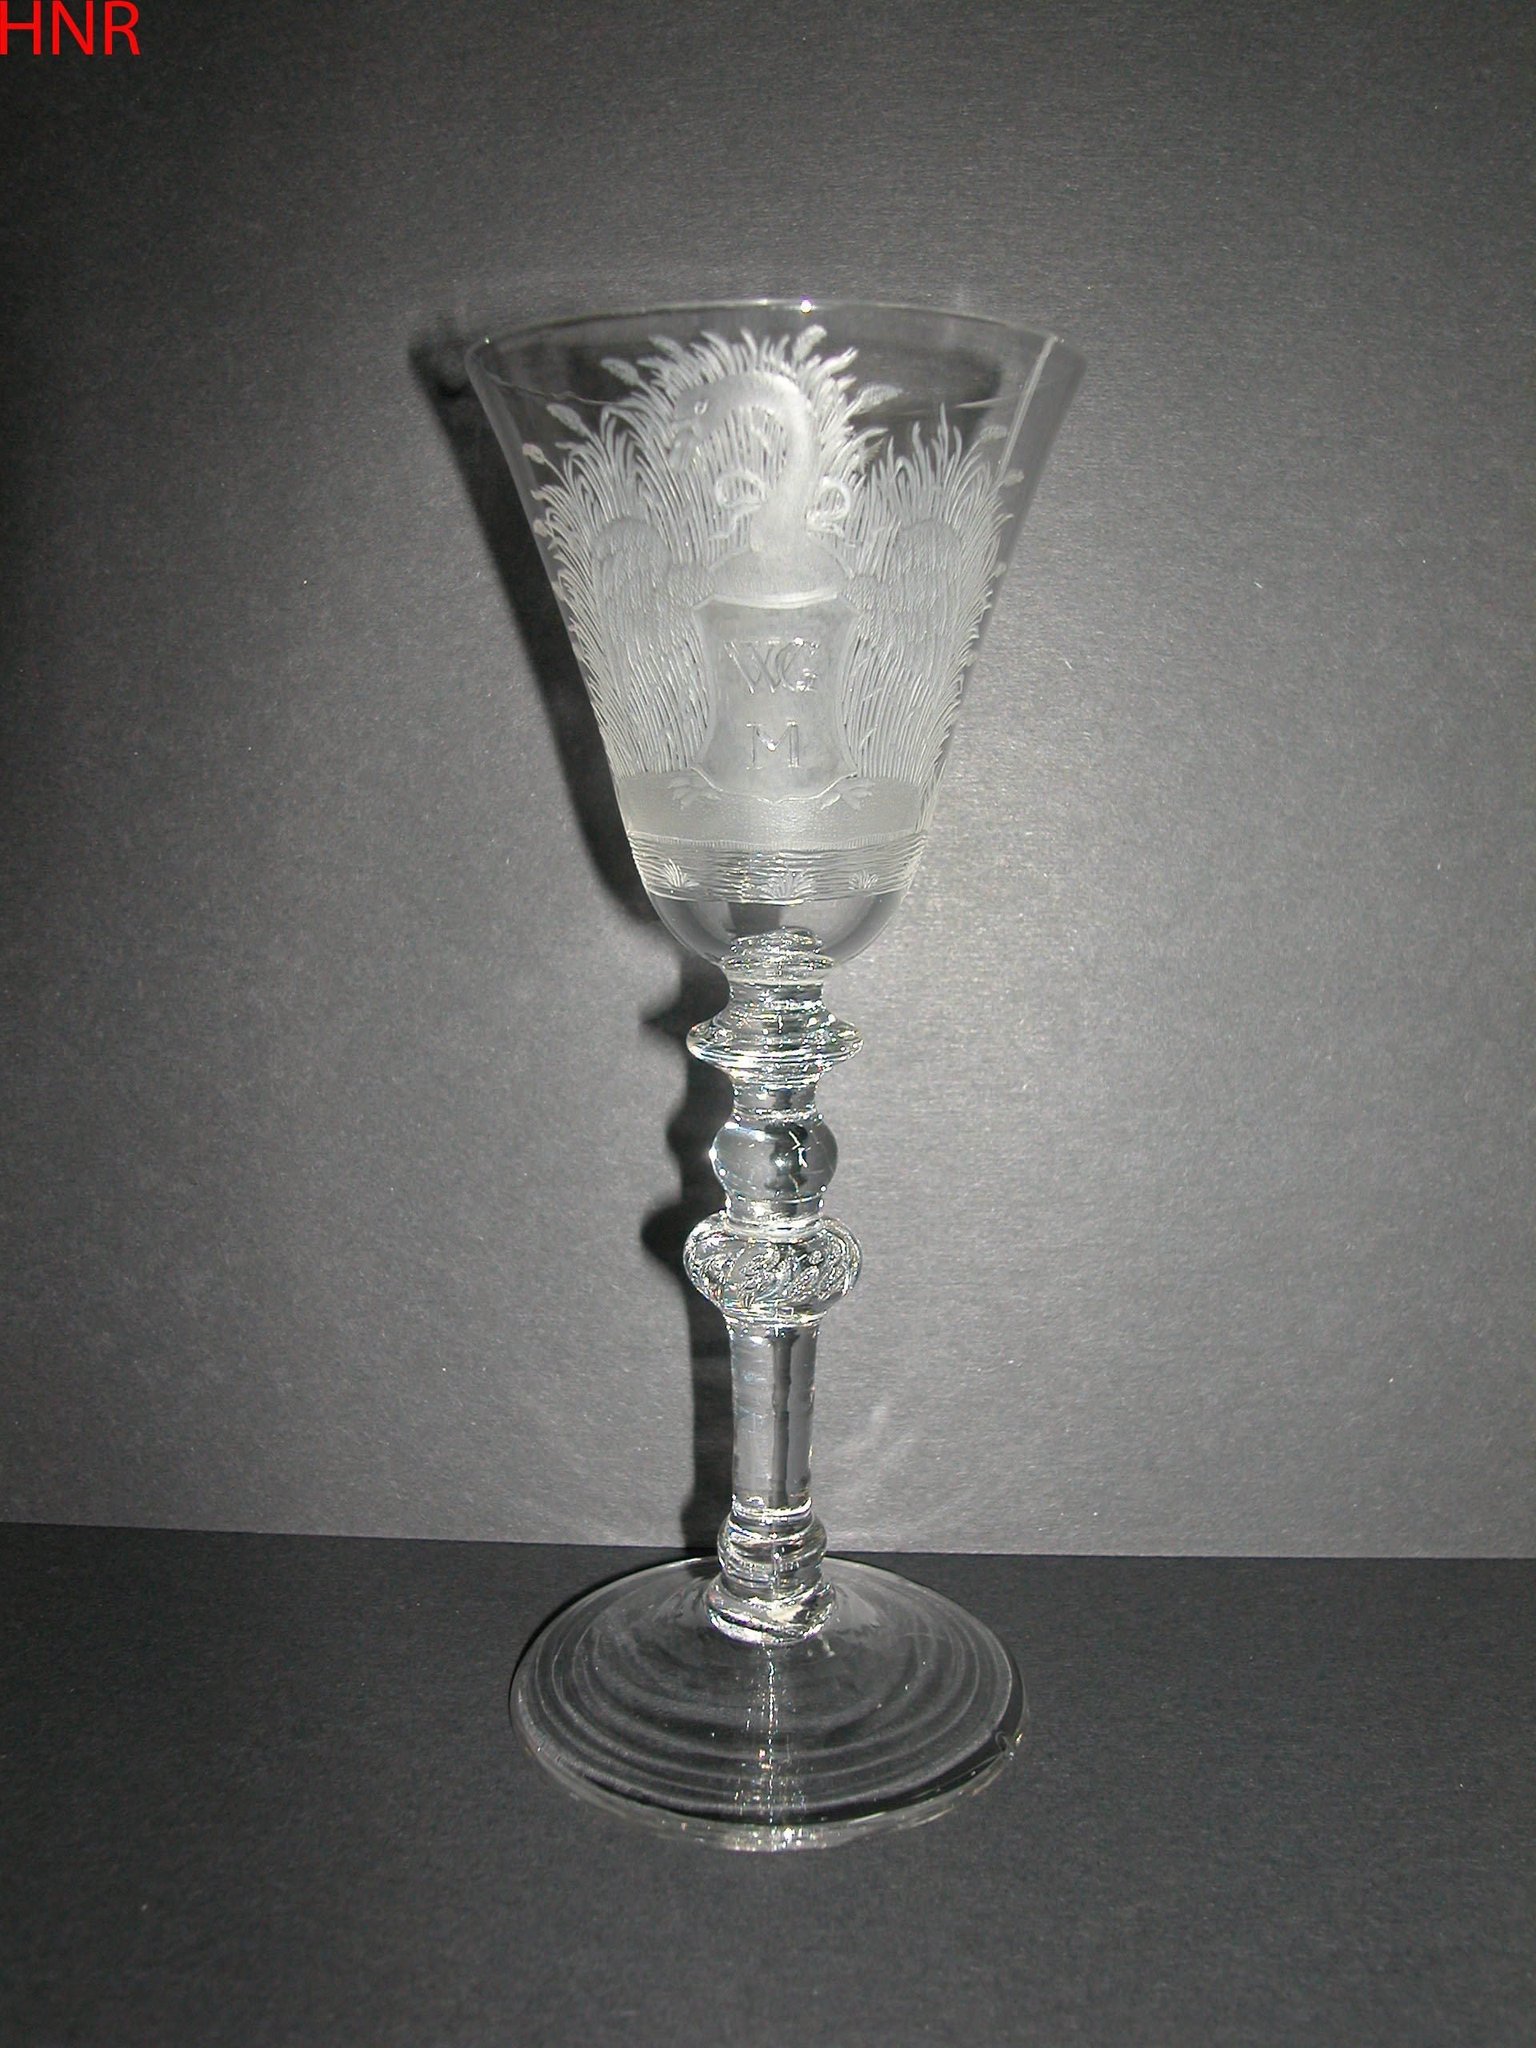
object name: goblet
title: Kelkglas met het wapen van de familie Van Heemskerk en het monogram WGM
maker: Anonymous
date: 1761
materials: glass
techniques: glassblowing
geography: northern netherlands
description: Watergraafsmeer Polder Board, c. 1761. On loan from the Koninklijk Oudheidkundig Genootschap.